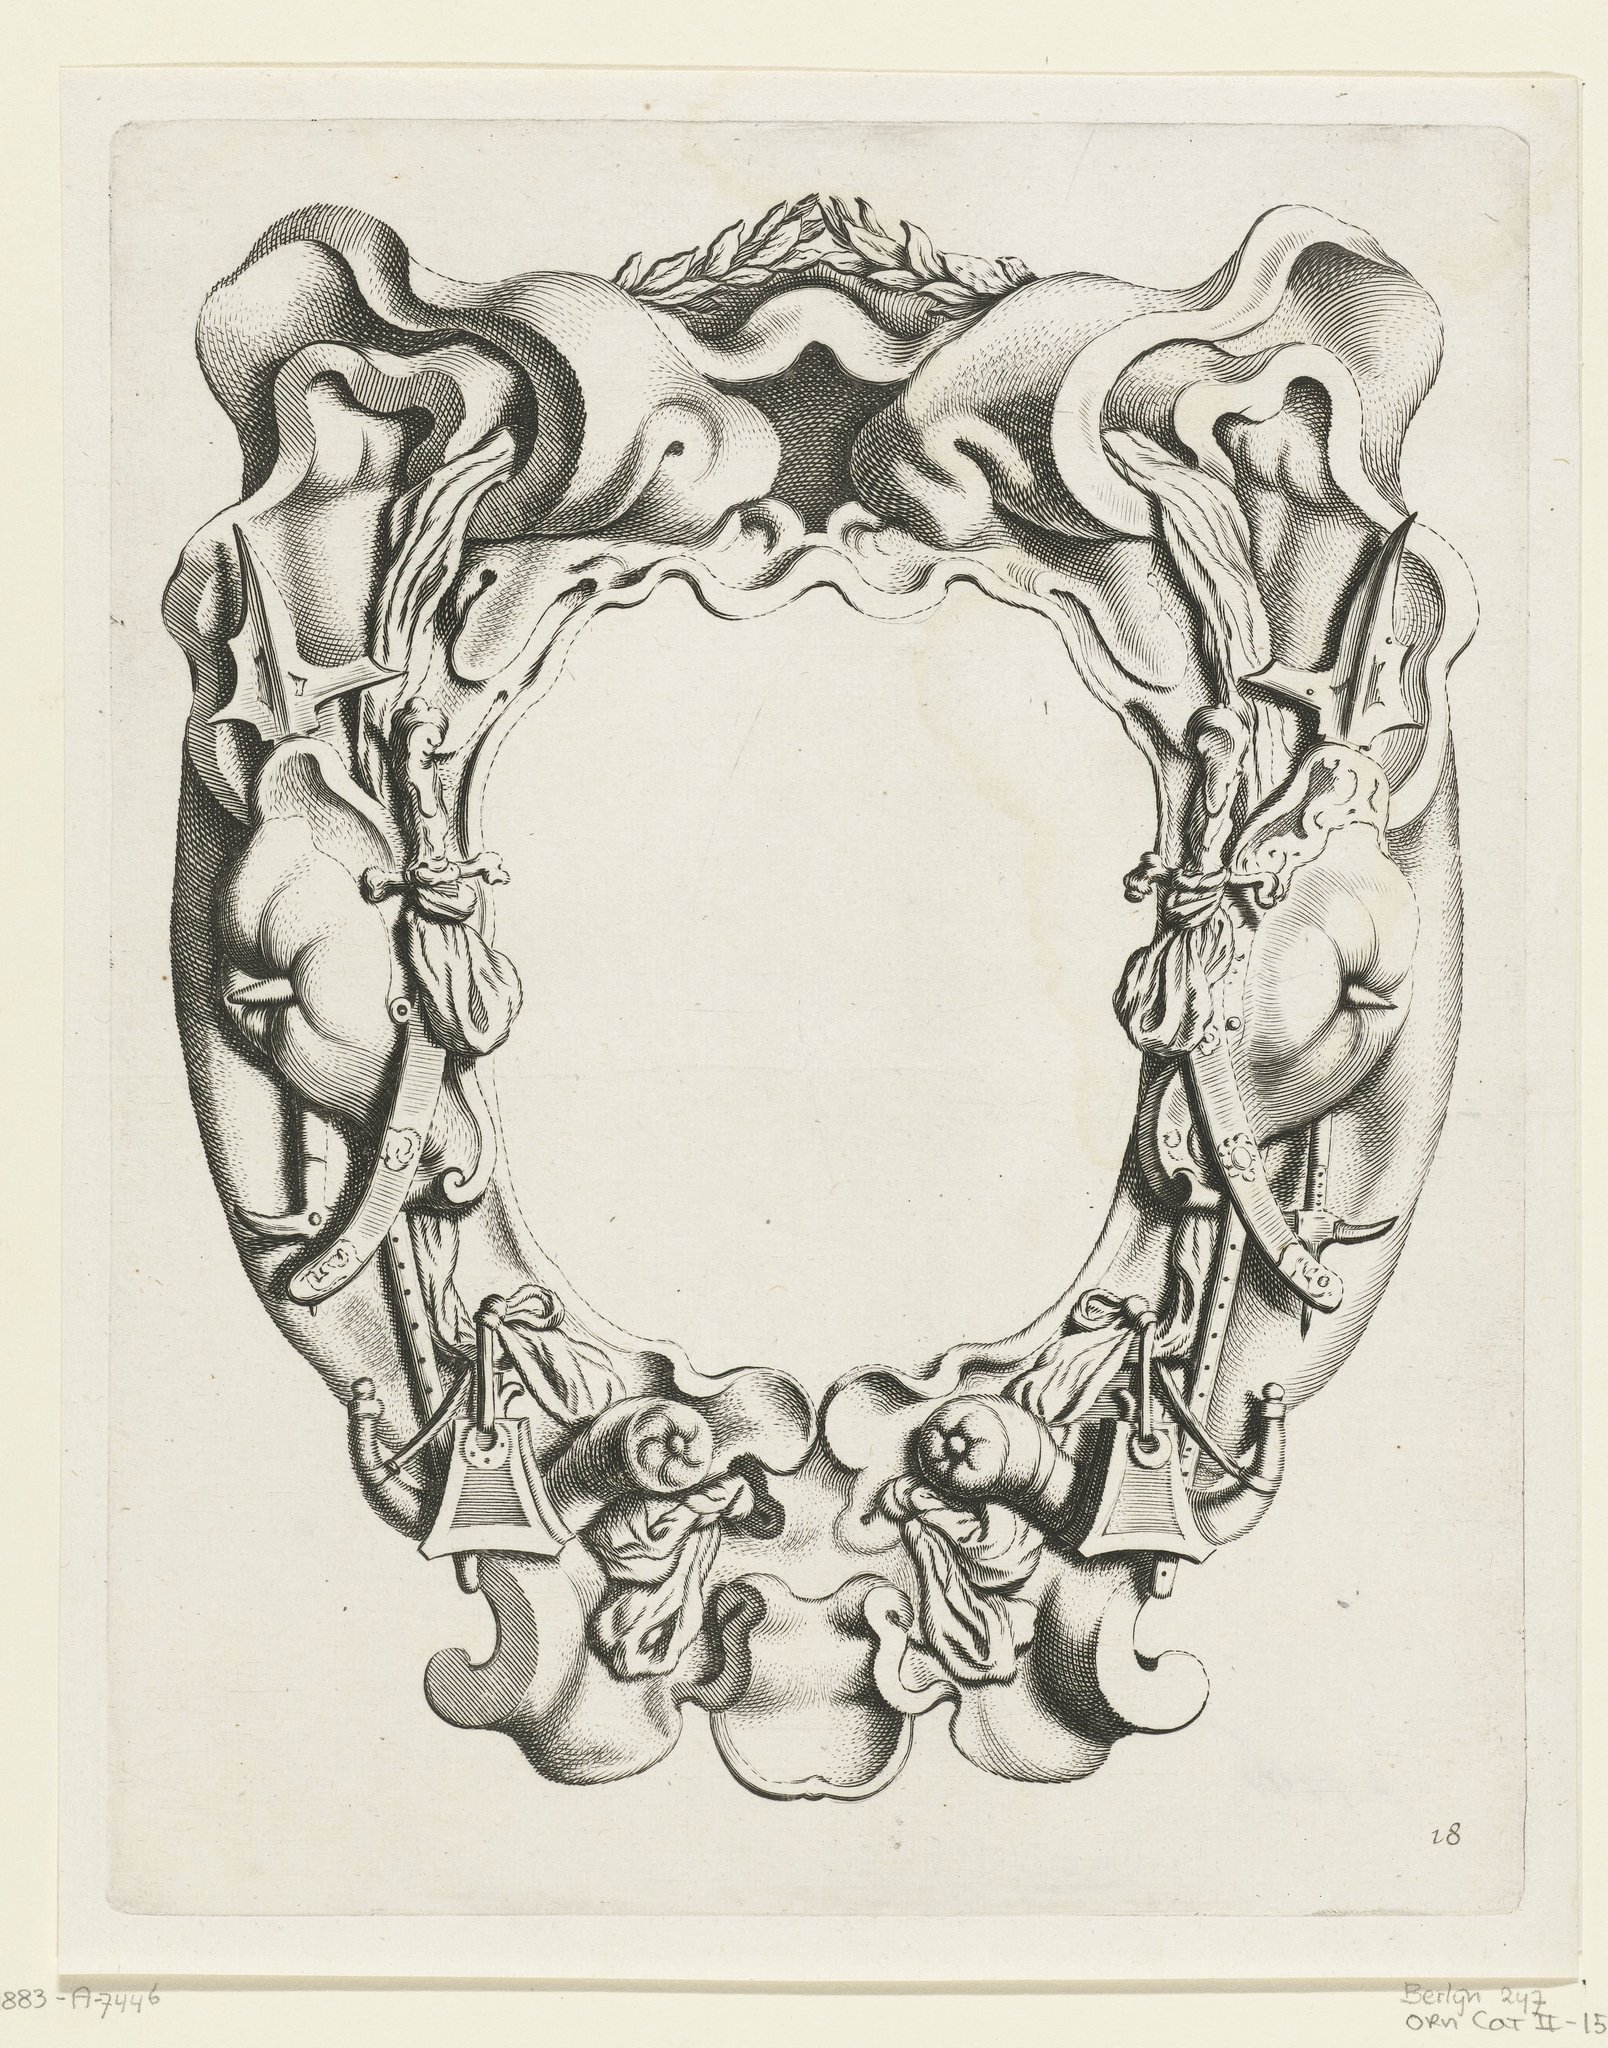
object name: ornament print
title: Cartouche met kwabornament met wapentrofeëen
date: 1640-1655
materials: paper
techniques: engraving, etching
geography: amsterdam